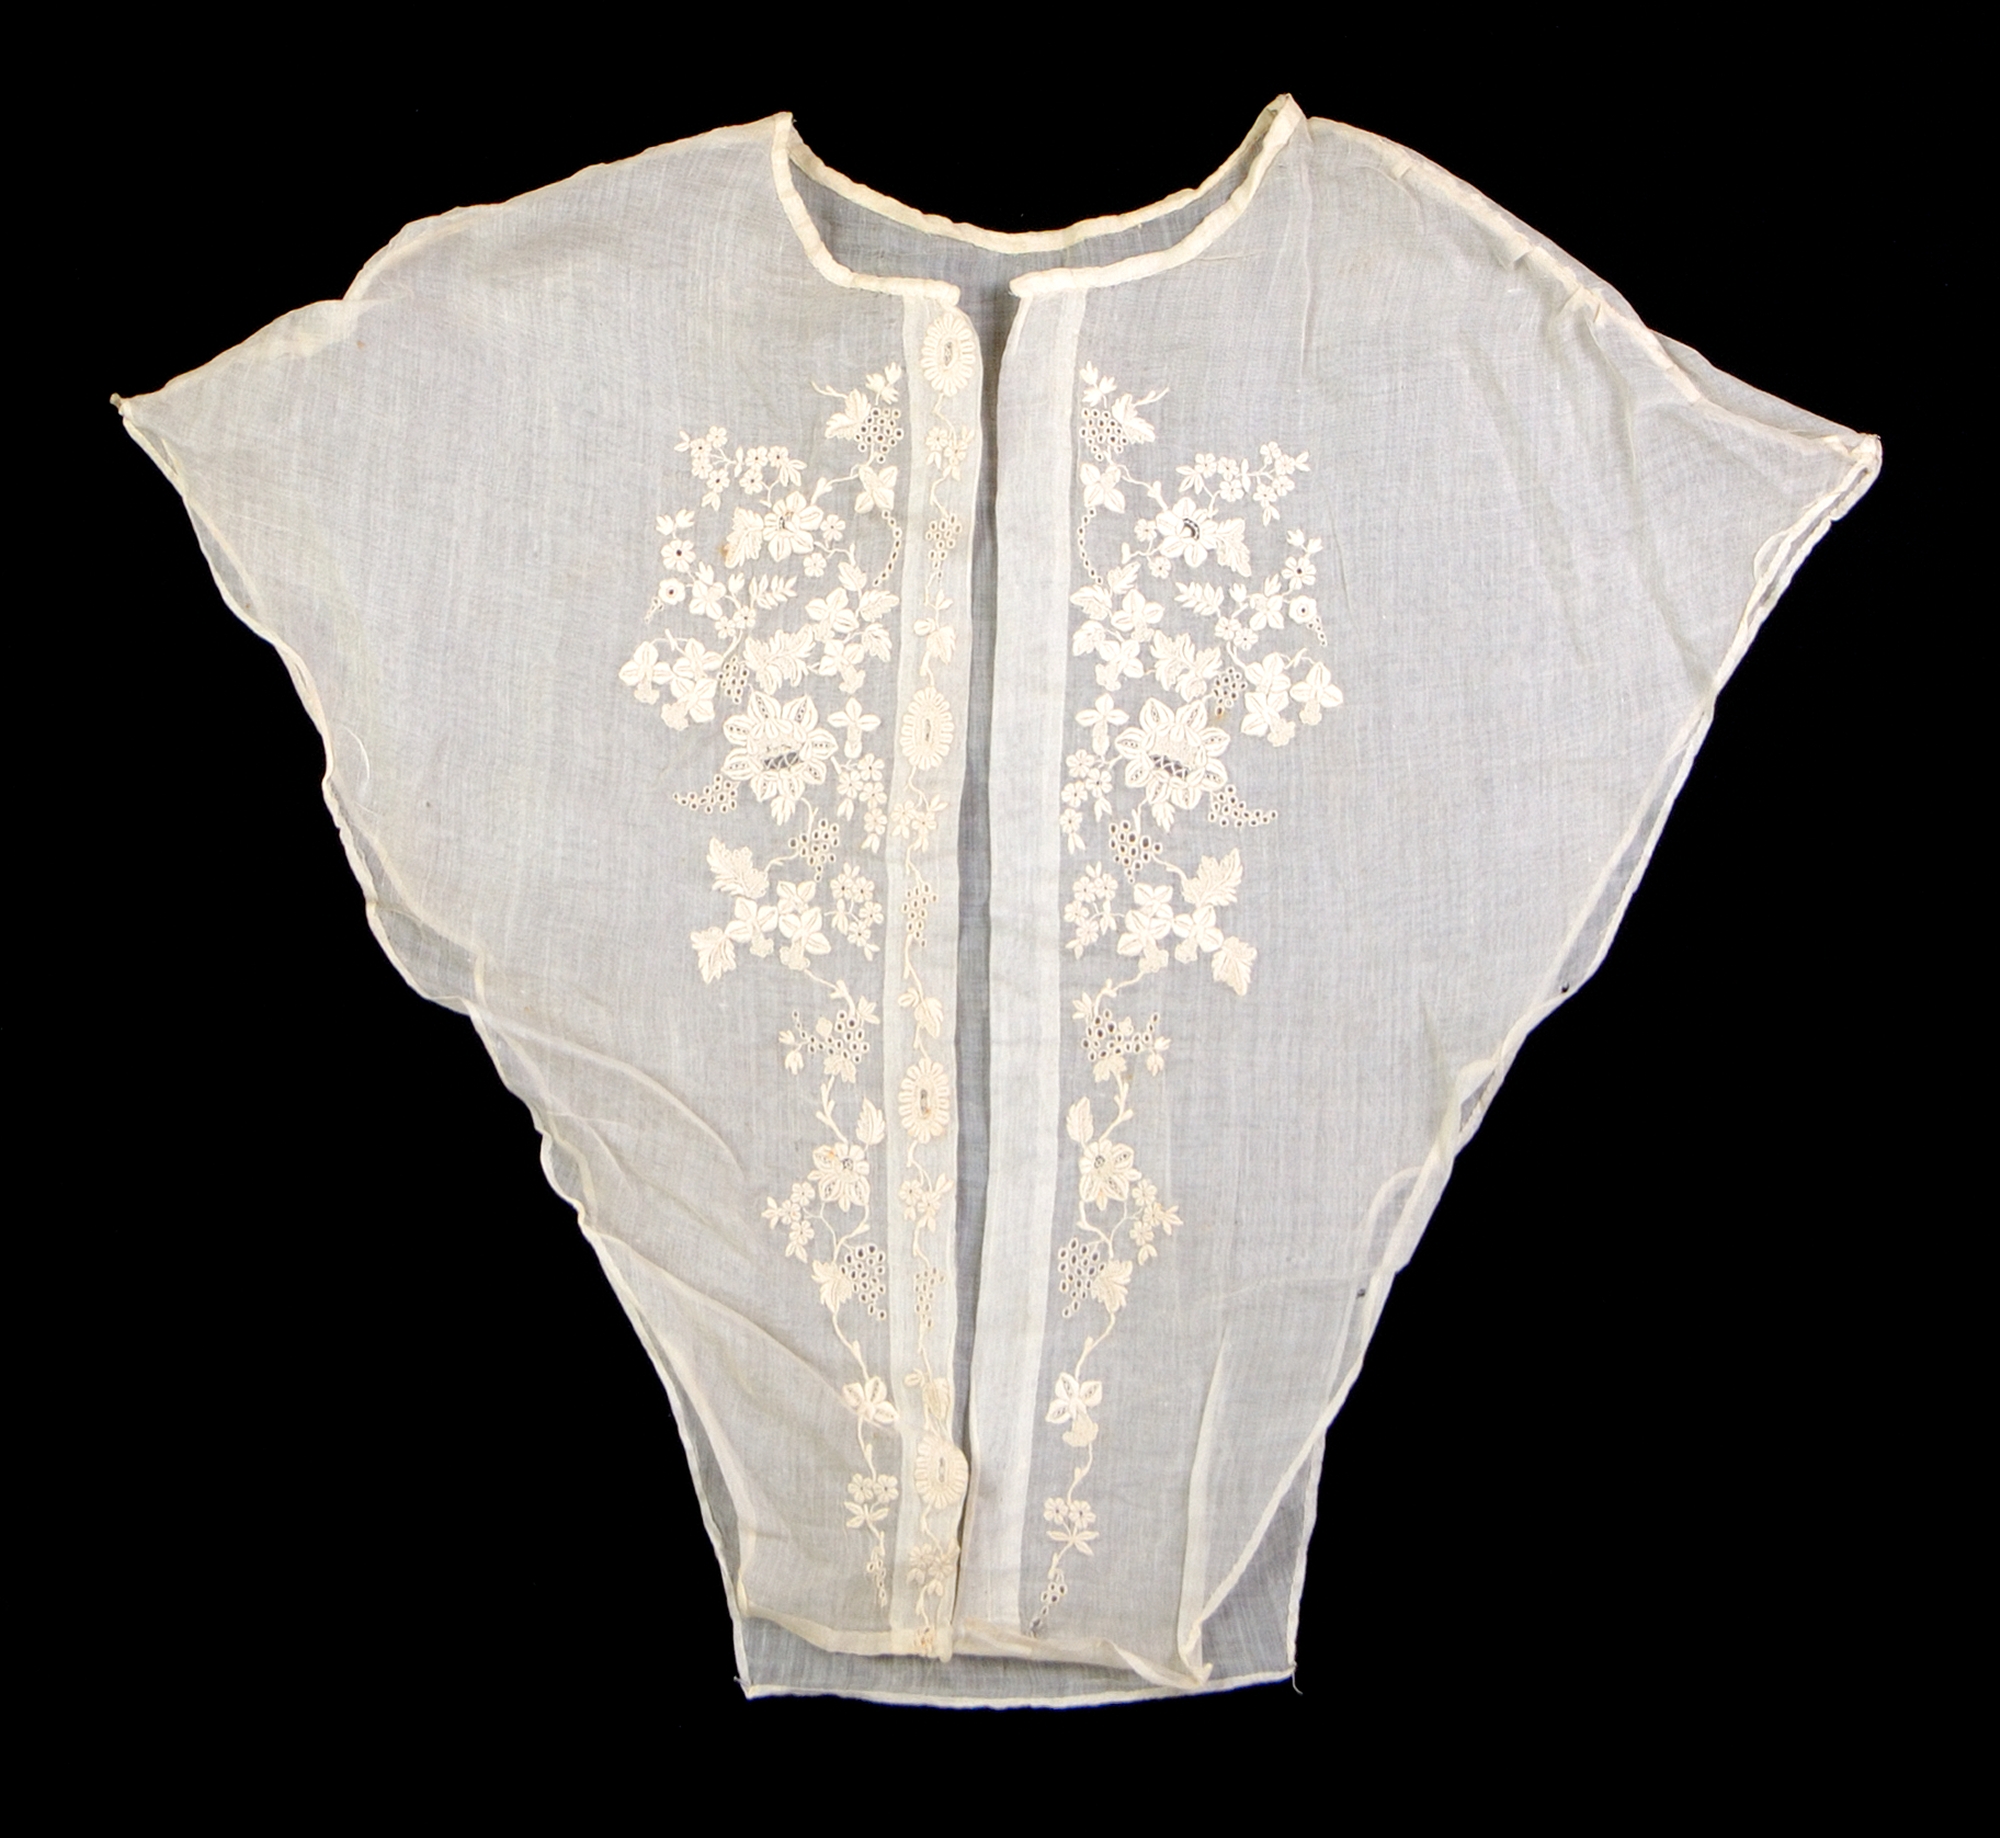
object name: chemise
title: Chemisette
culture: american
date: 1850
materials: cotton